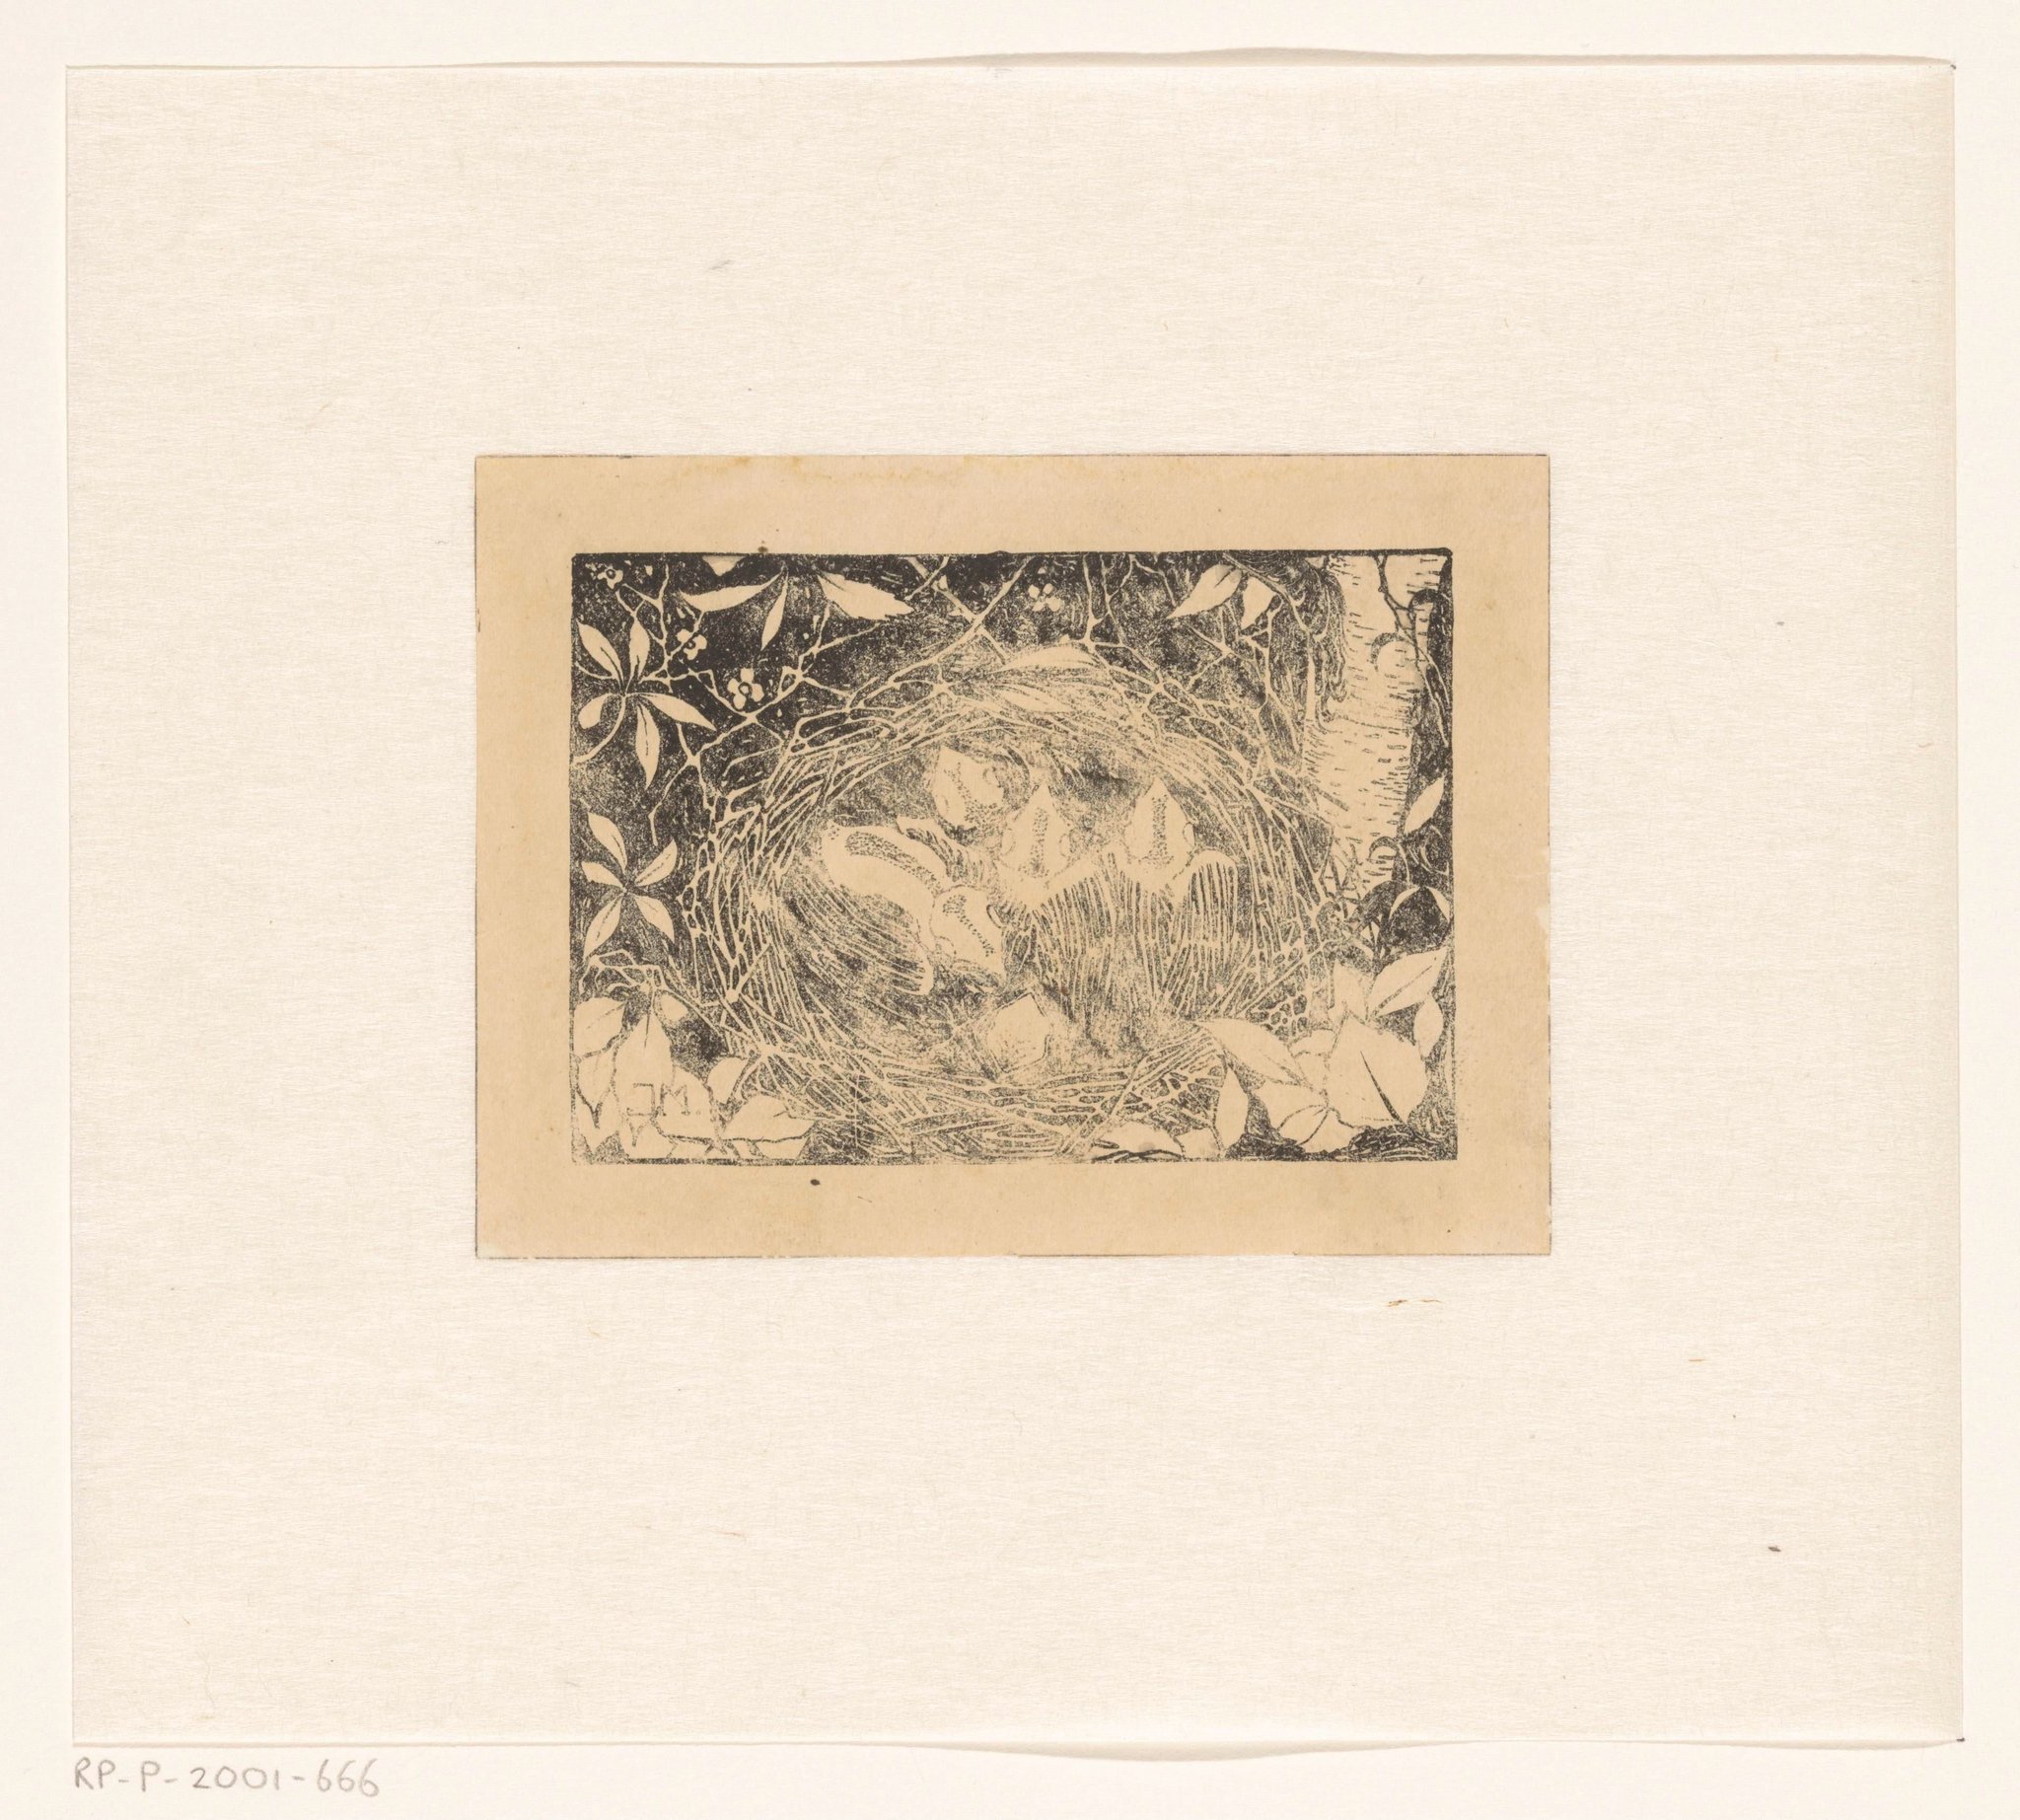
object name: print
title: Vogelnest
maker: jan mankes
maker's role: draughtsman, painter, print maker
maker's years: 1889-1920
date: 1912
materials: paper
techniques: lithograph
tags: birds (+ young animal)